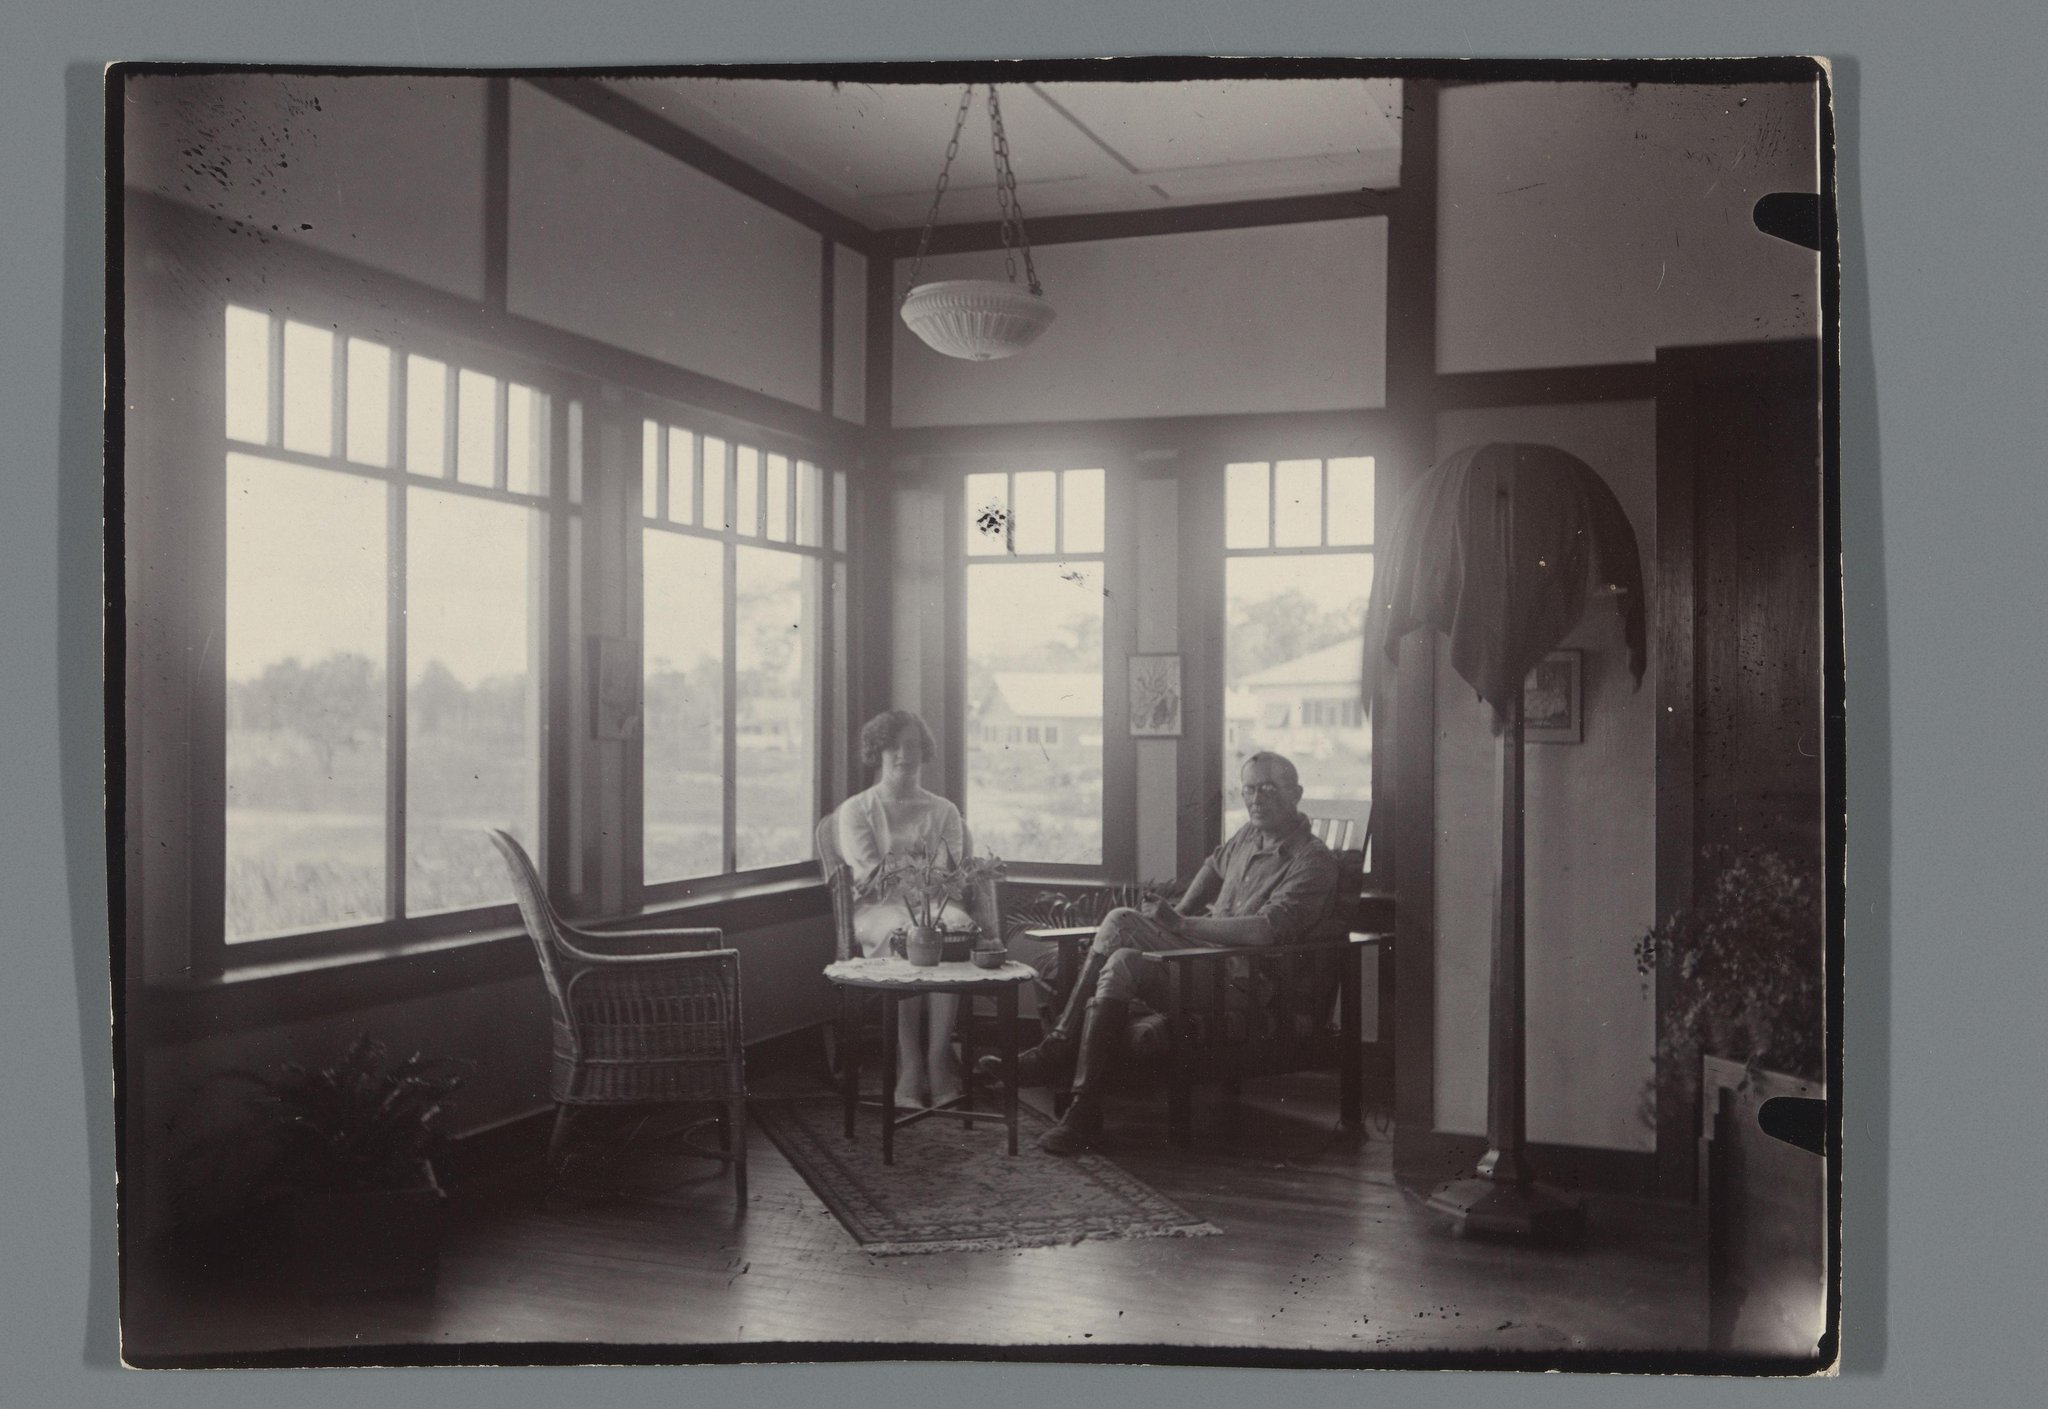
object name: photograph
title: Echtpaar Jetten in huiskamer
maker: Anonymous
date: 1925-1927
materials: photographic support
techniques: photography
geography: suriname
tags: jetten, familie, moengo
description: Echtpaar ingenieur en Edith Jetten zittend in de huiskamer van hun huis te Moengo. Onderdeel van het ensemble met foto's van de familie van ingenieur Jetten in de mijnbouwstad Moengo in Suriname.